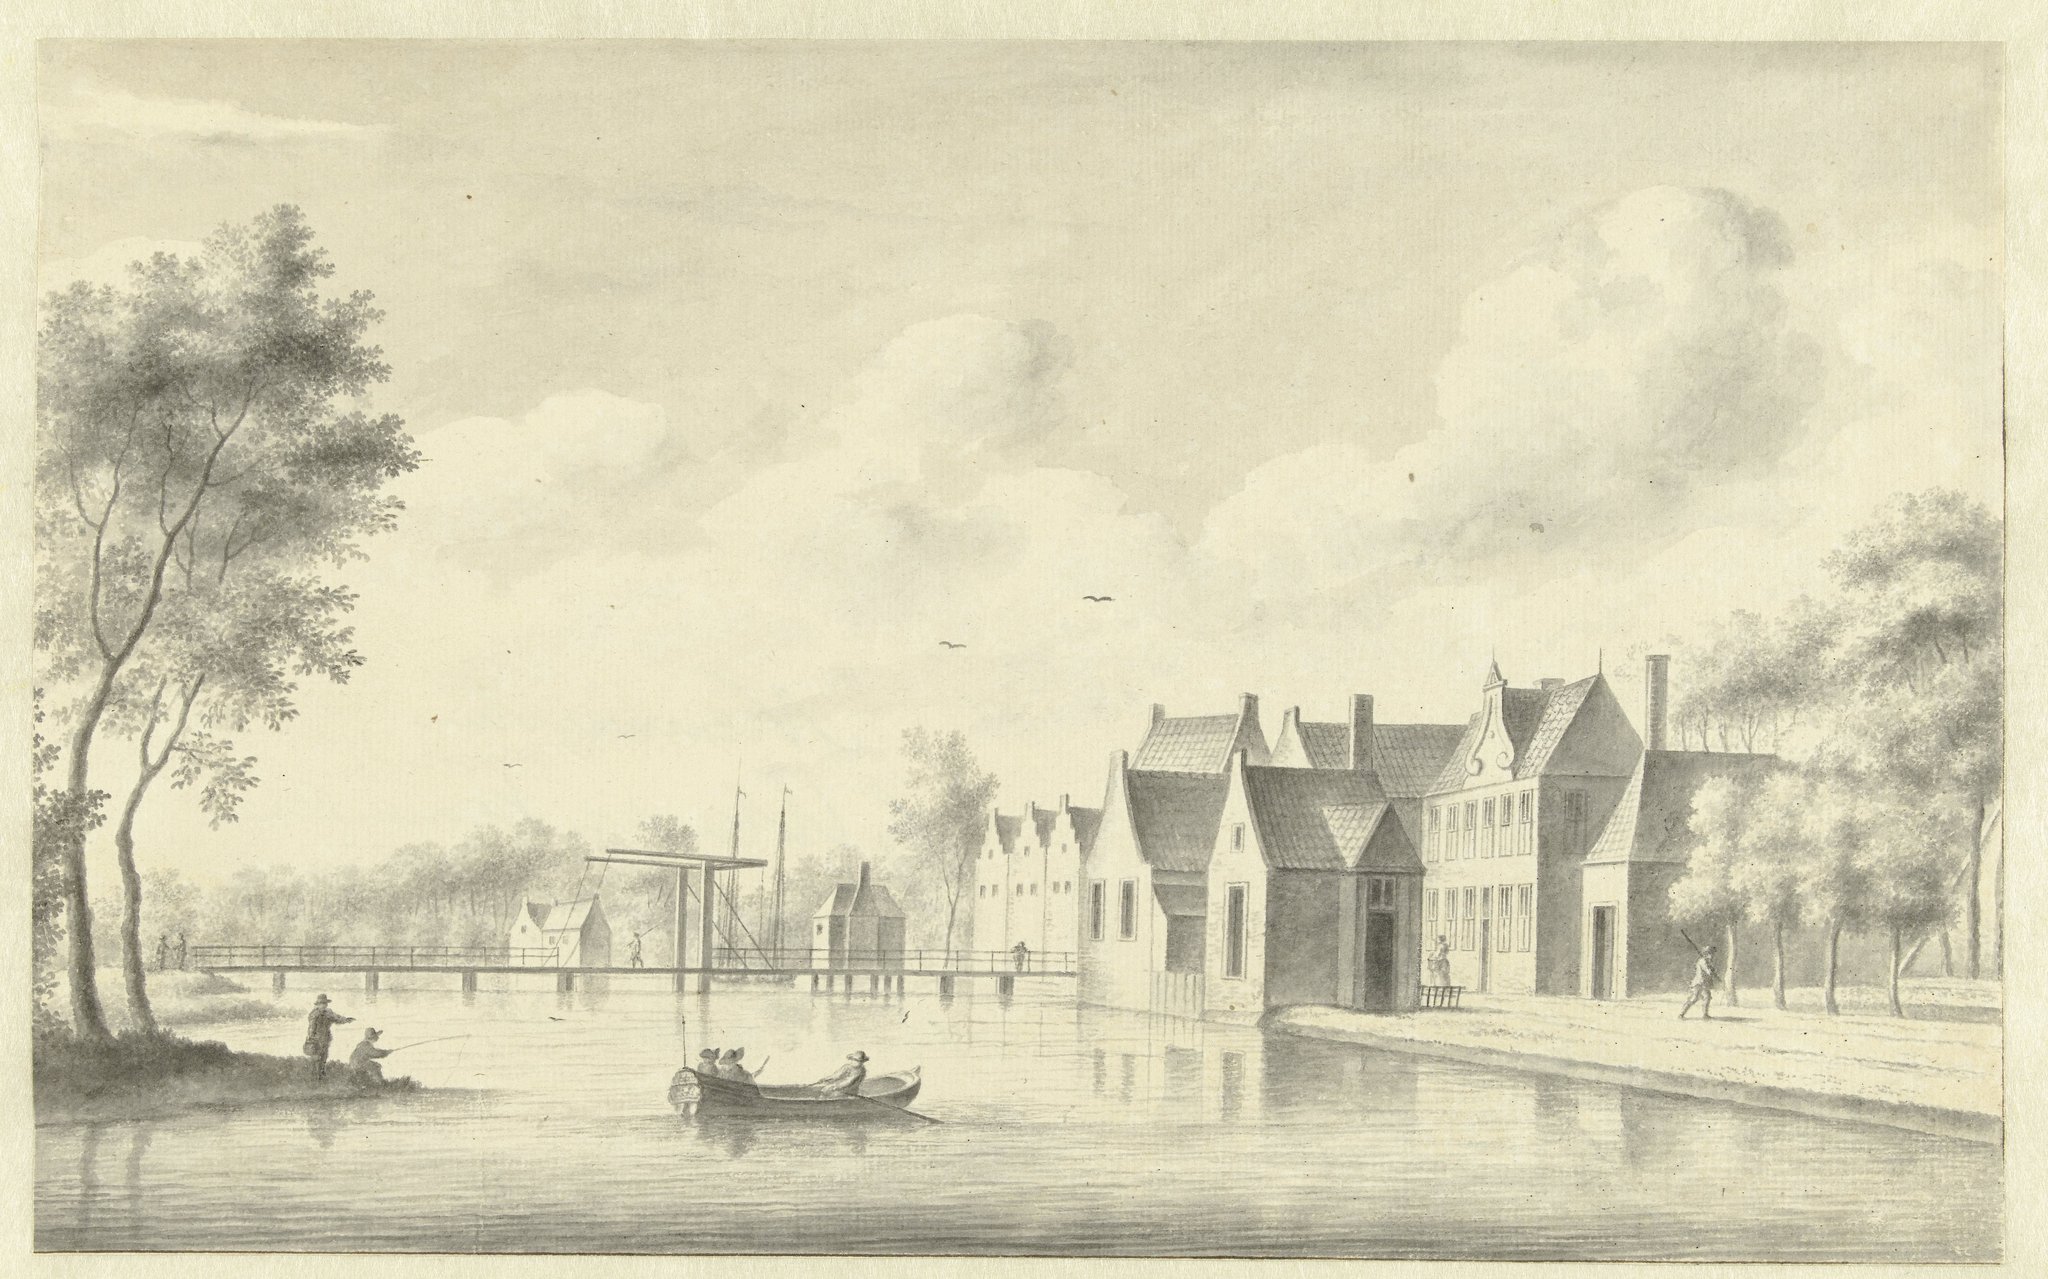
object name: drawing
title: Gezicht op het dorp Nieuwersluis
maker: abraham rademaker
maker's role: draughtsman, print maker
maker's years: 1676-1735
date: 1722-1733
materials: ink, paper, pencil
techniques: brush, pen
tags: prospect of village, silhouette of village